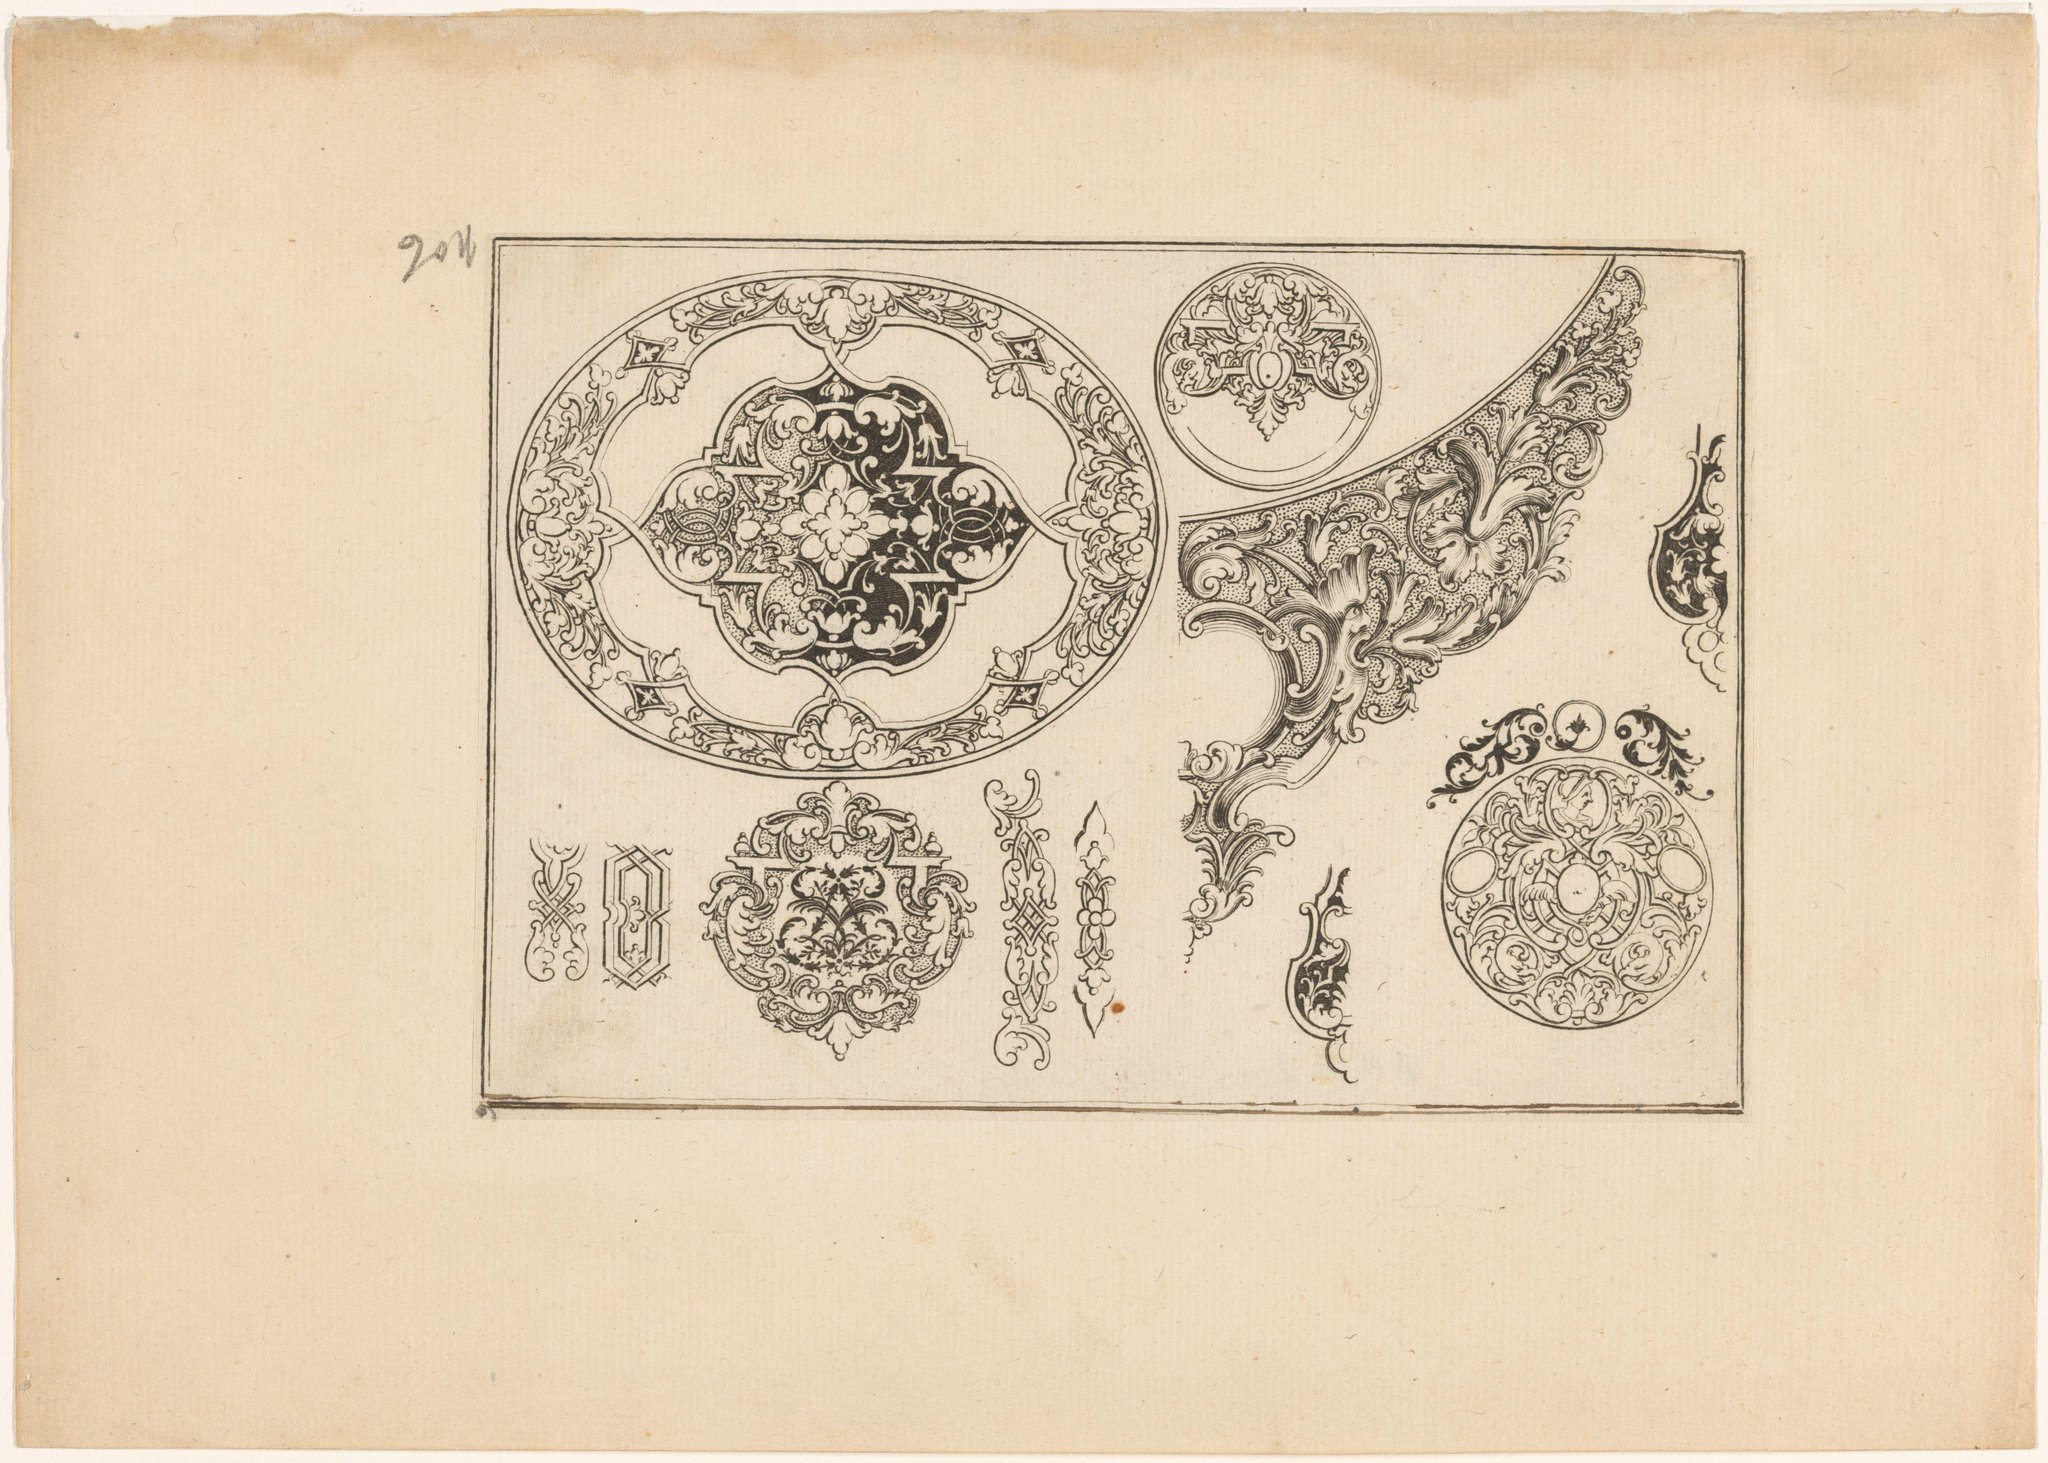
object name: print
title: Verscheidene ontwerpen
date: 1703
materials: paper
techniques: etching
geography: germany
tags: ornaments ~ art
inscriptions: collector's mark: Lugt 2228, collector's mark: Lugt 2760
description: Gespiegelde Duitse kopie van Pierre Bourdon's Livre Premier, Livre Second end Livre Troisieme: Essais de gravure (1703). Blad uit serie van zeven van ontwerpen voor horlogemakers, goudsmeden, beeldhouwers en graveurs.